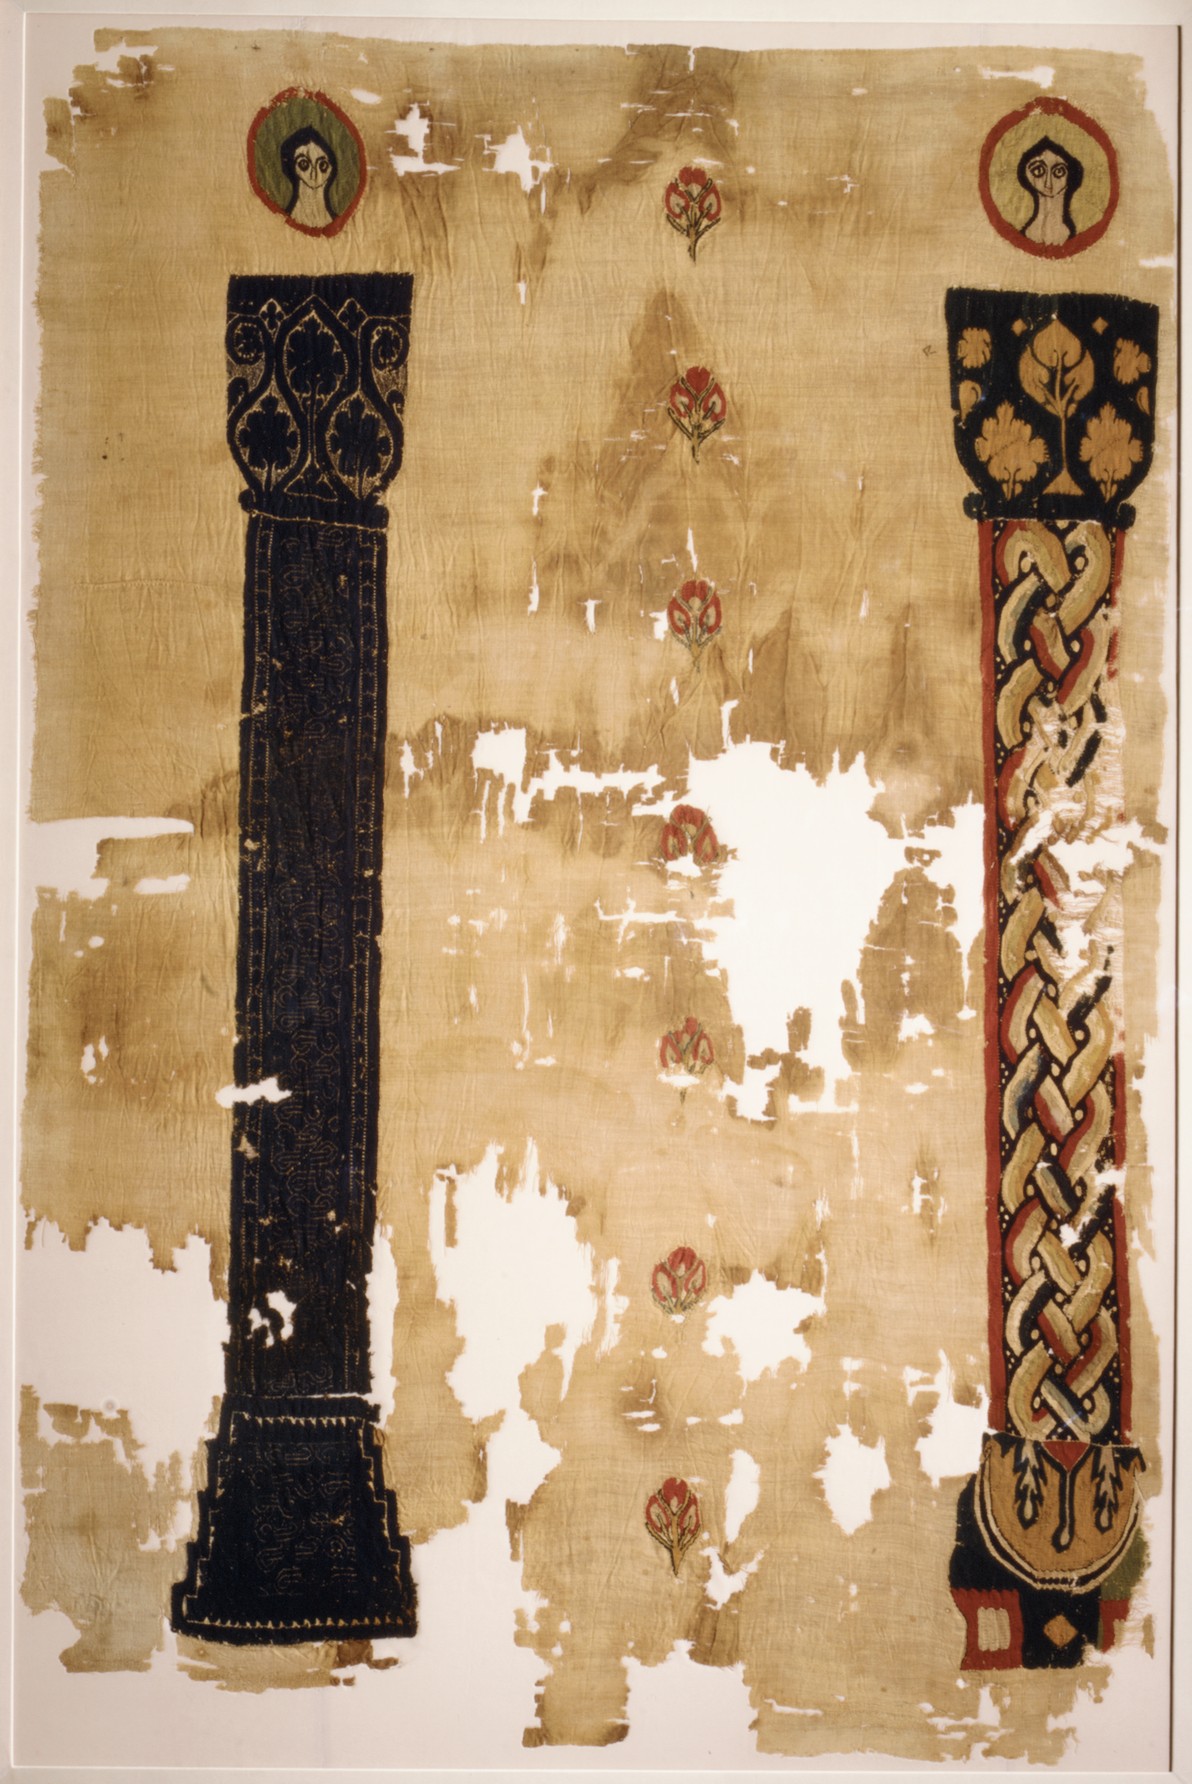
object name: hanging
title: Hanging with Polychrome Columns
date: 401-600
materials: linen, wool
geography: egypt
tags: columns